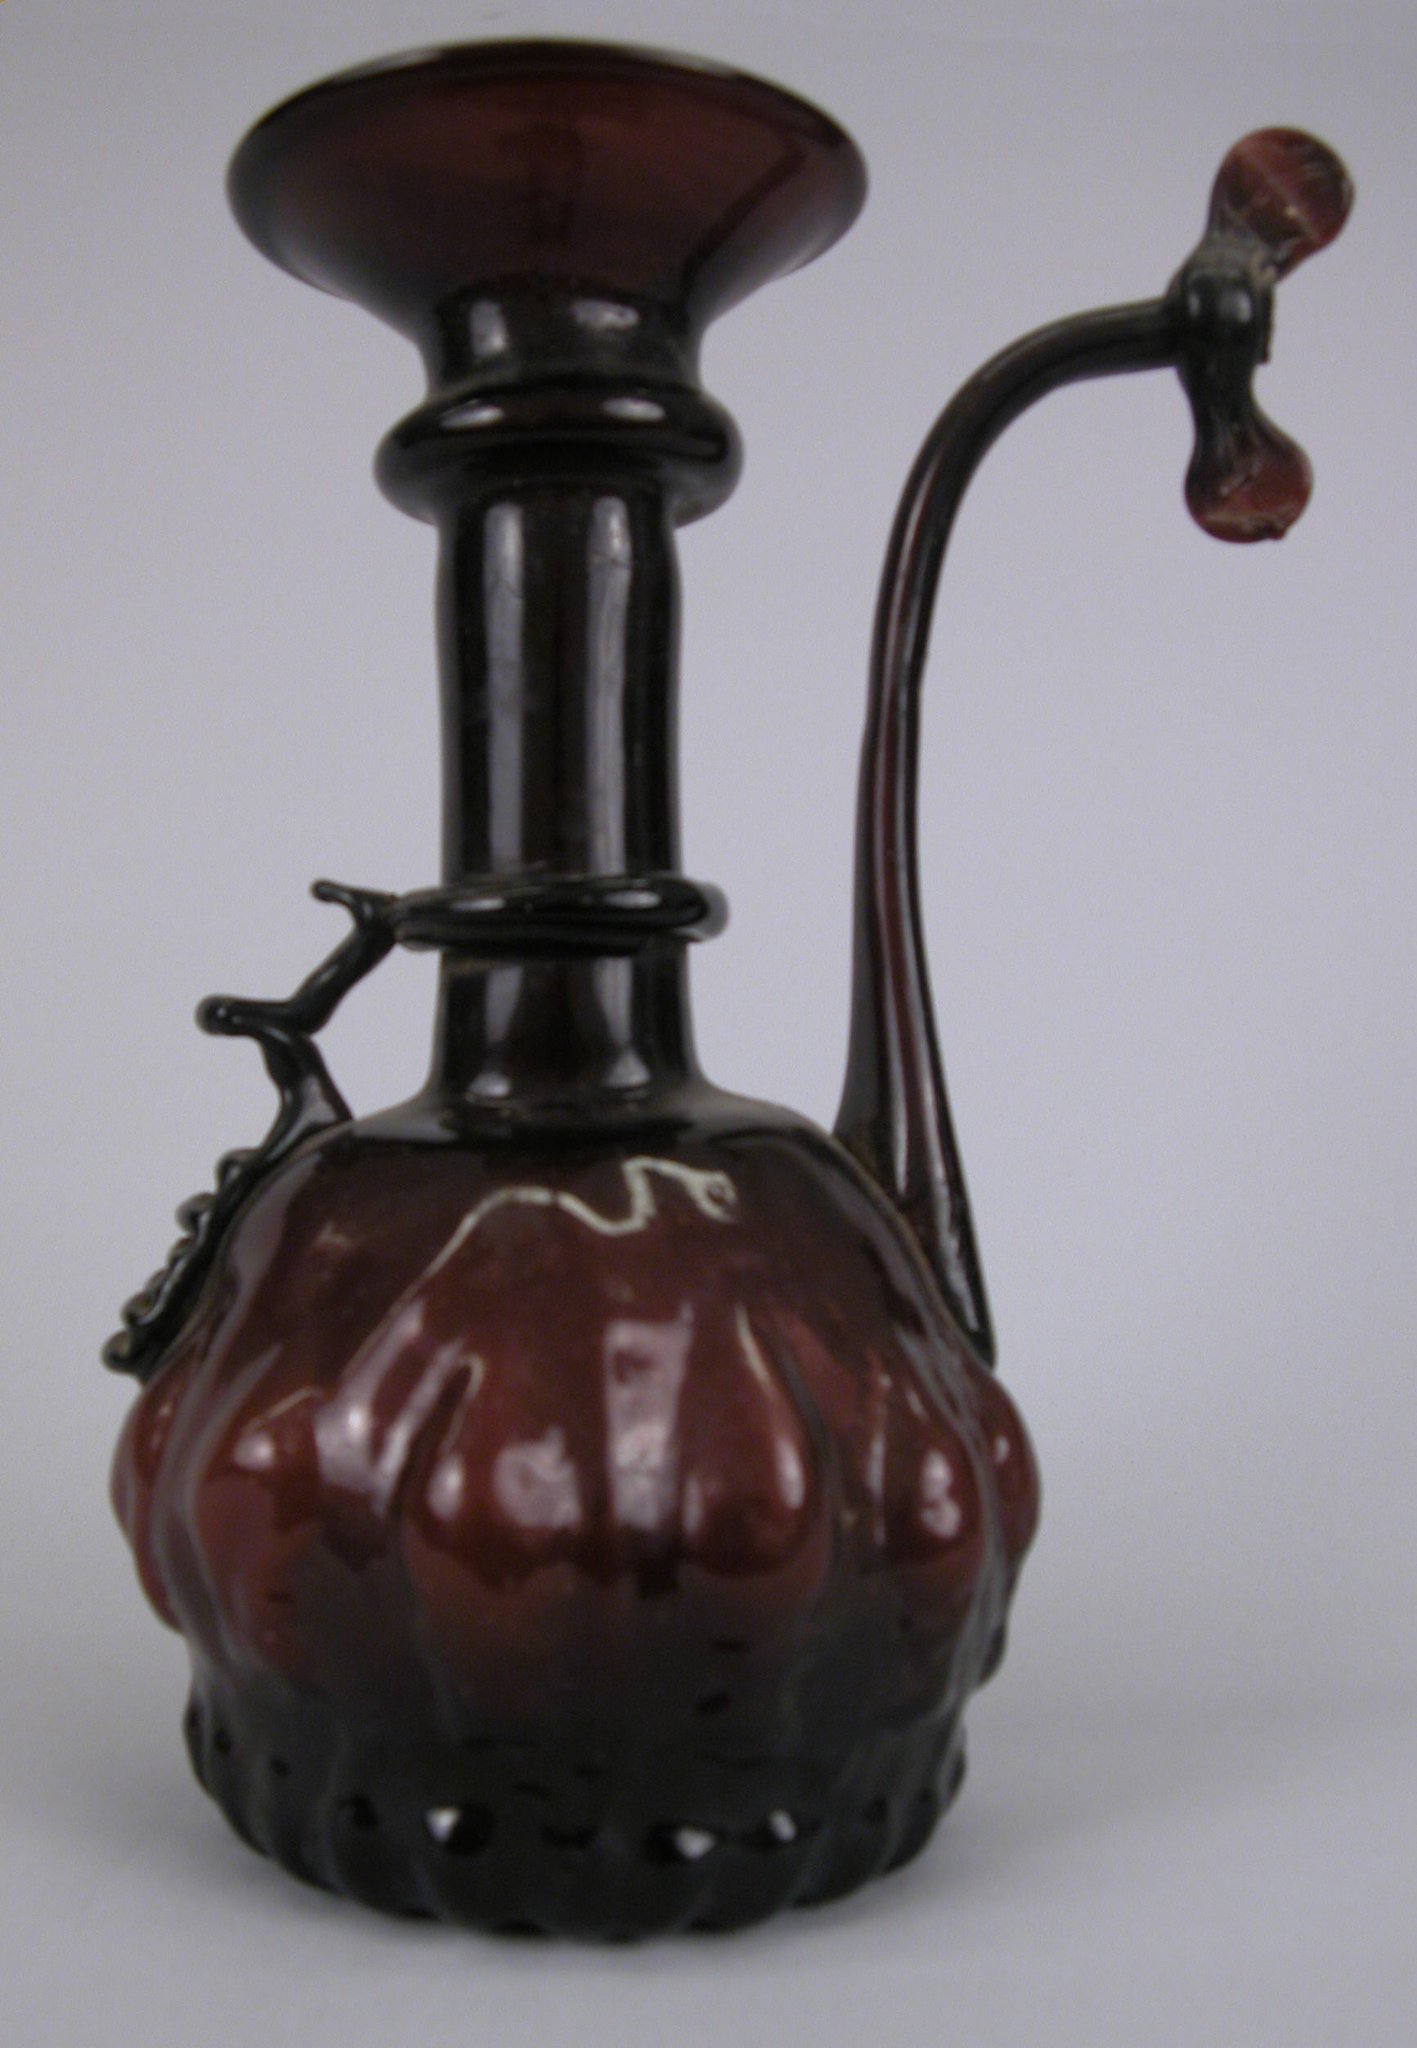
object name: ewer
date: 1701-1900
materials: glass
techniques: glassblowing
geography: iran